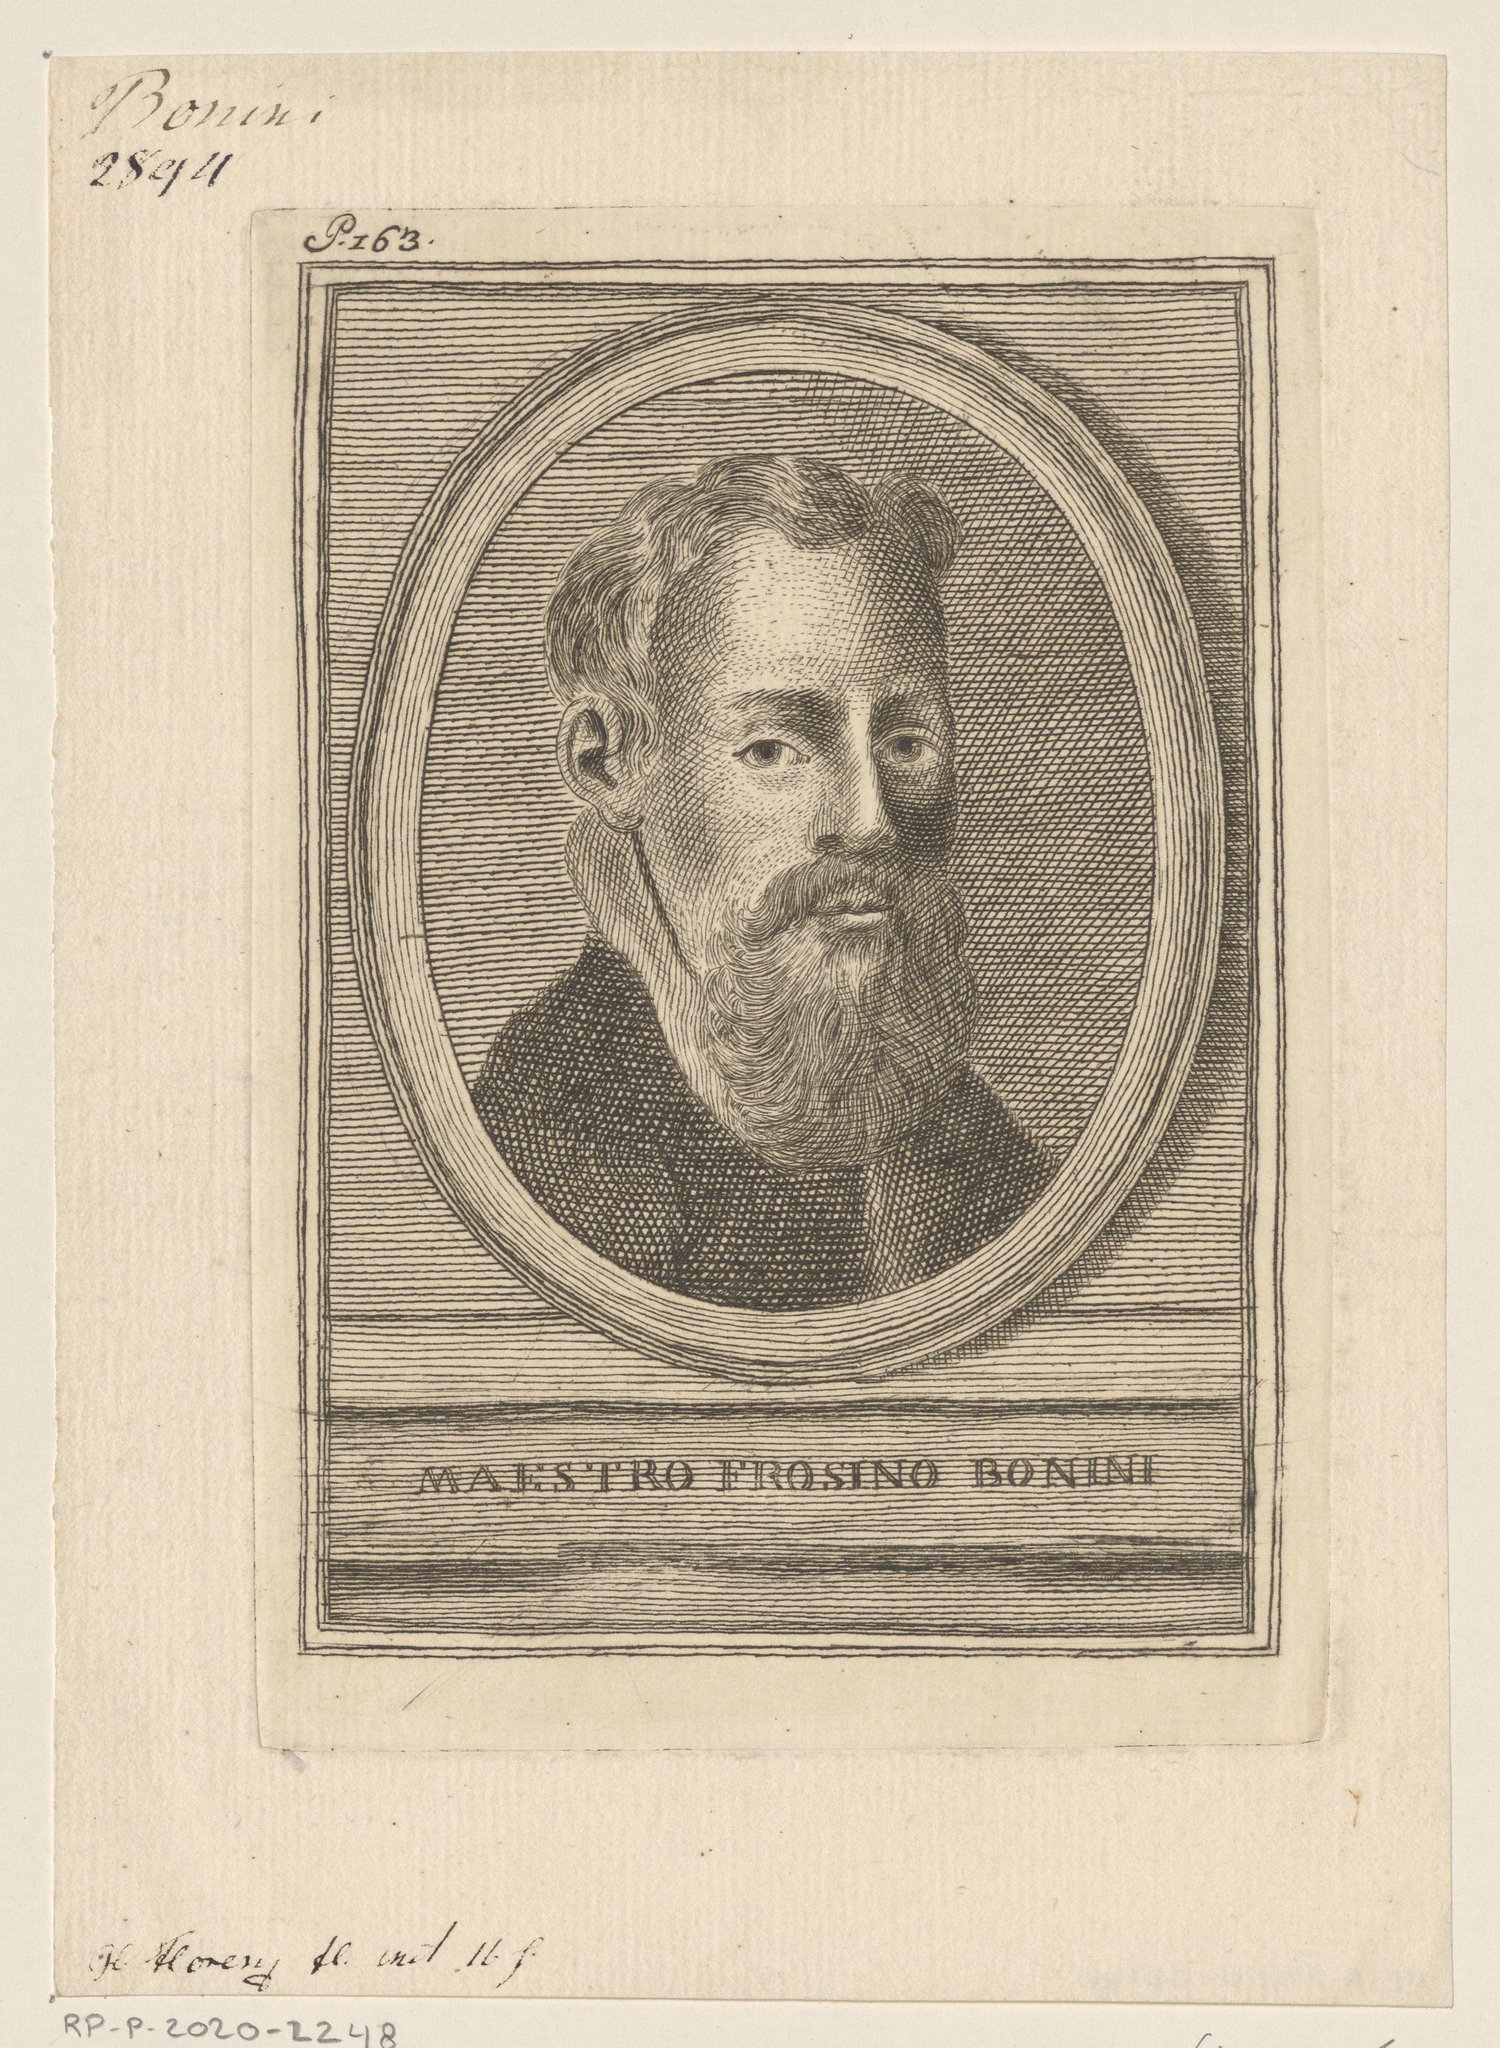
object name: book illustration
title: Portret van Frosino Bonini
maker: Anonymous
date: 1600-1699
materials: paper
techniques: engraving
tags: historical persons, professor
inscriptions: inscription: ‘[...]’